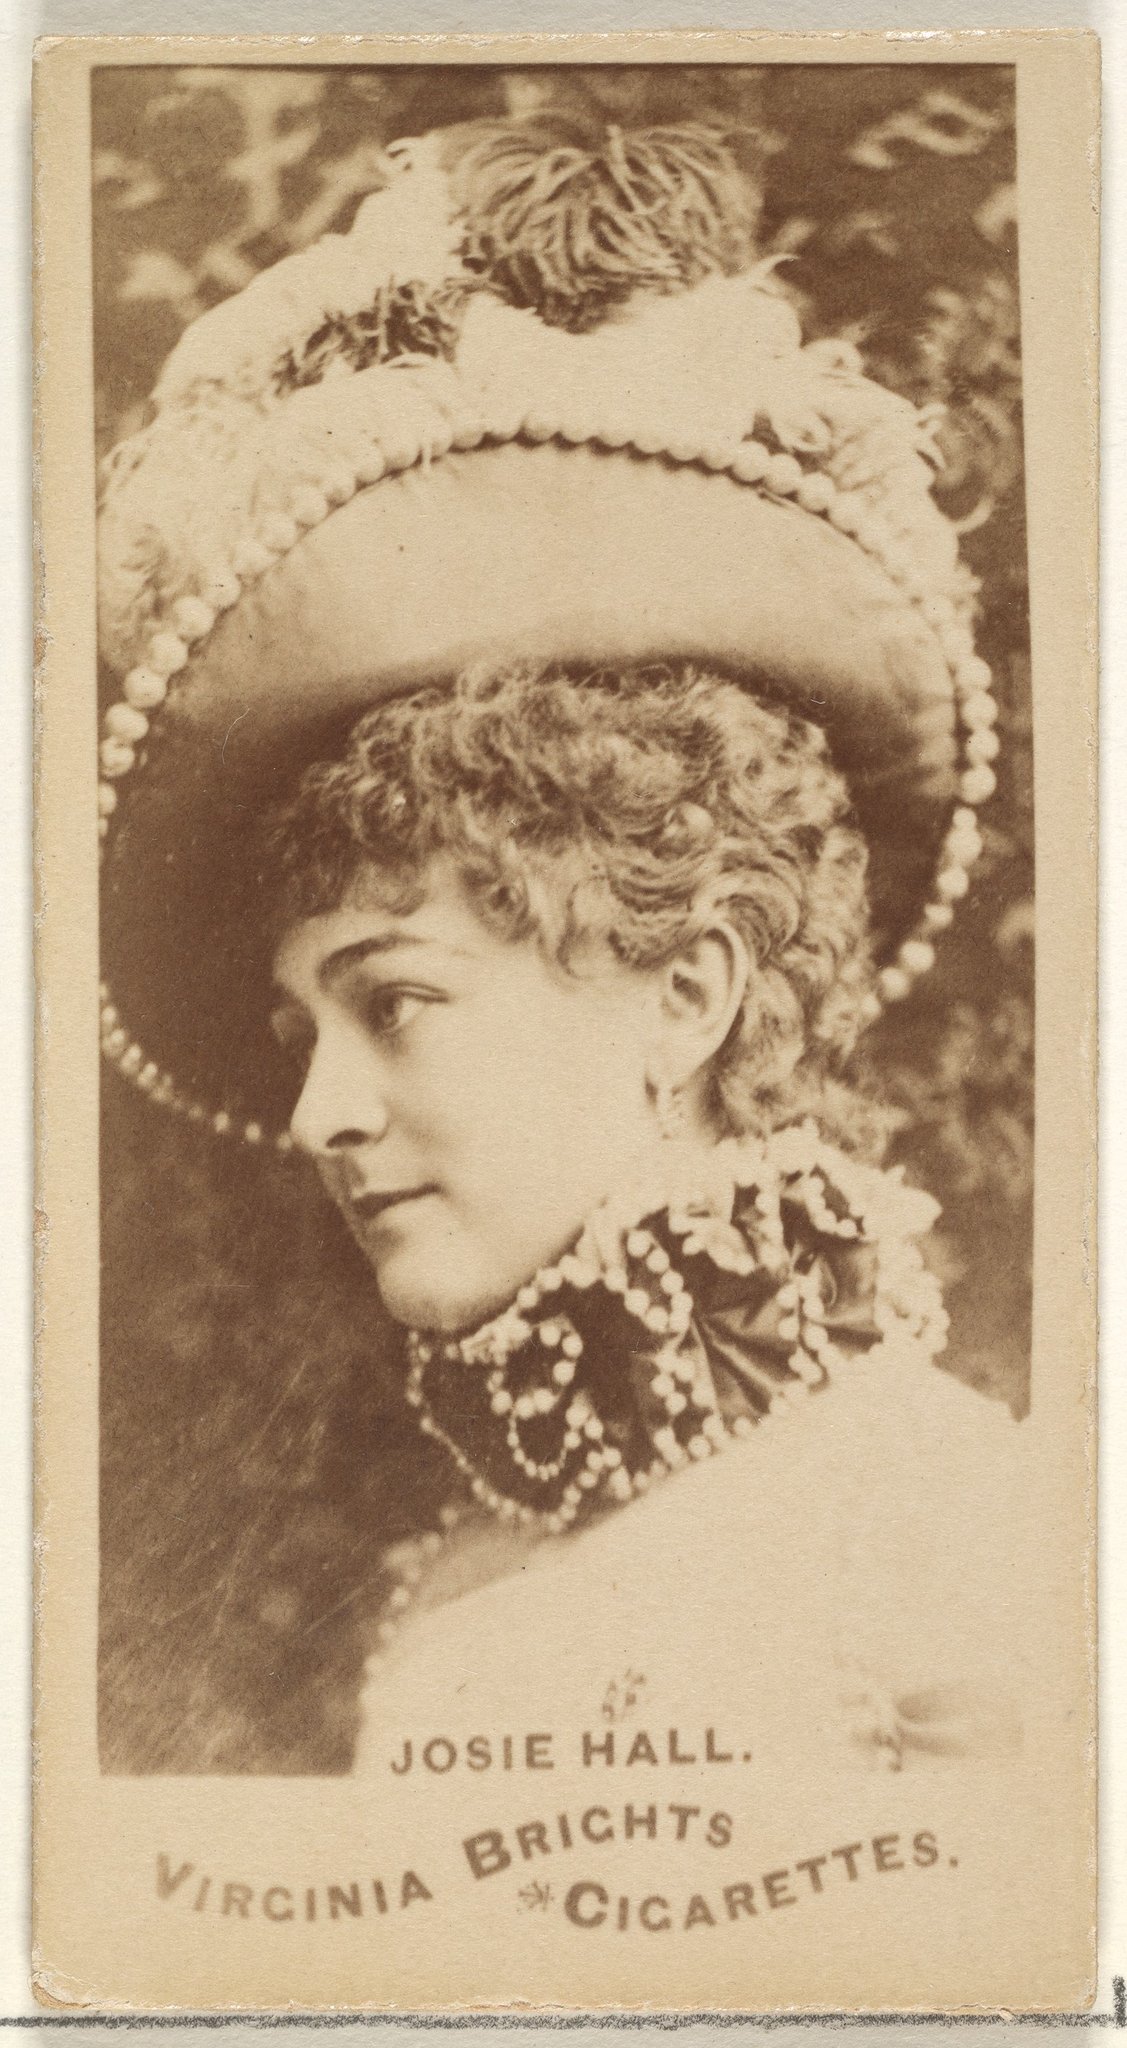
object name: photograph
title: Josie Hall, from the Actors and Actresses series (N45, Type 1) for Virginia Brights Cigarettes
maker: allen & ginter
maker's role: publisher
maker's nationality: american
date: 1888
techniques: albumen silver print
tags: portraits,women,actresses